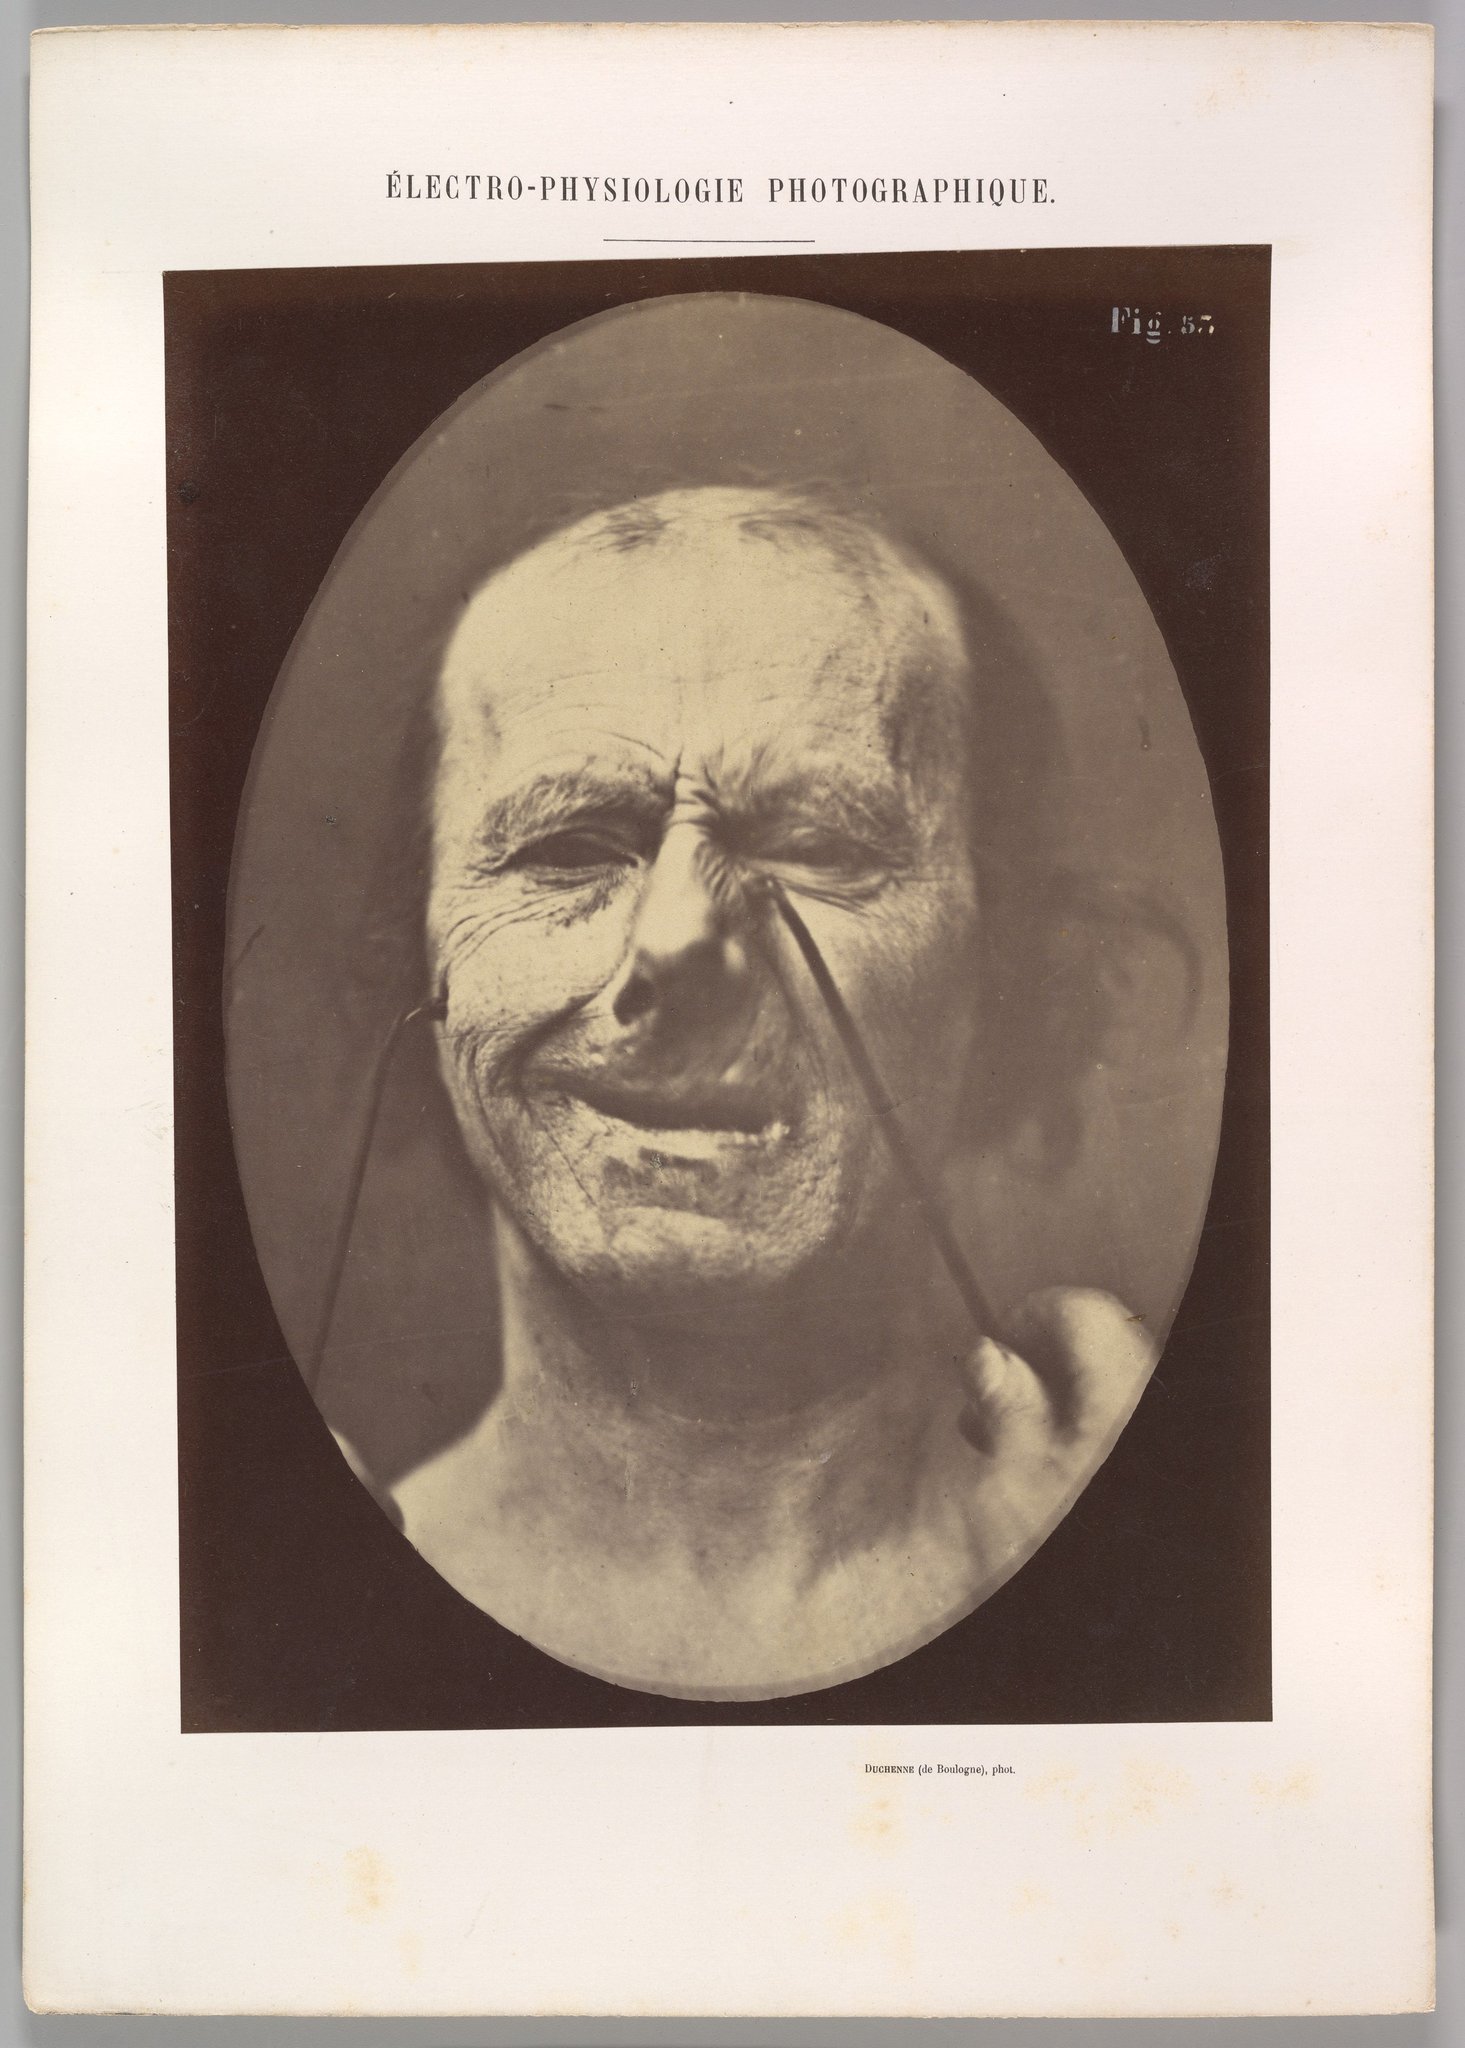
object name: photograph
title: Figure 53: Whimpering and false laughter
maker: guillaume-benjamin-amand duchenne de boulogne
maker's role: artist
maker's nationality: french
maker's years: 1806-1875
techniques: albumen silver print, glass negative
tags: science,men,portraits